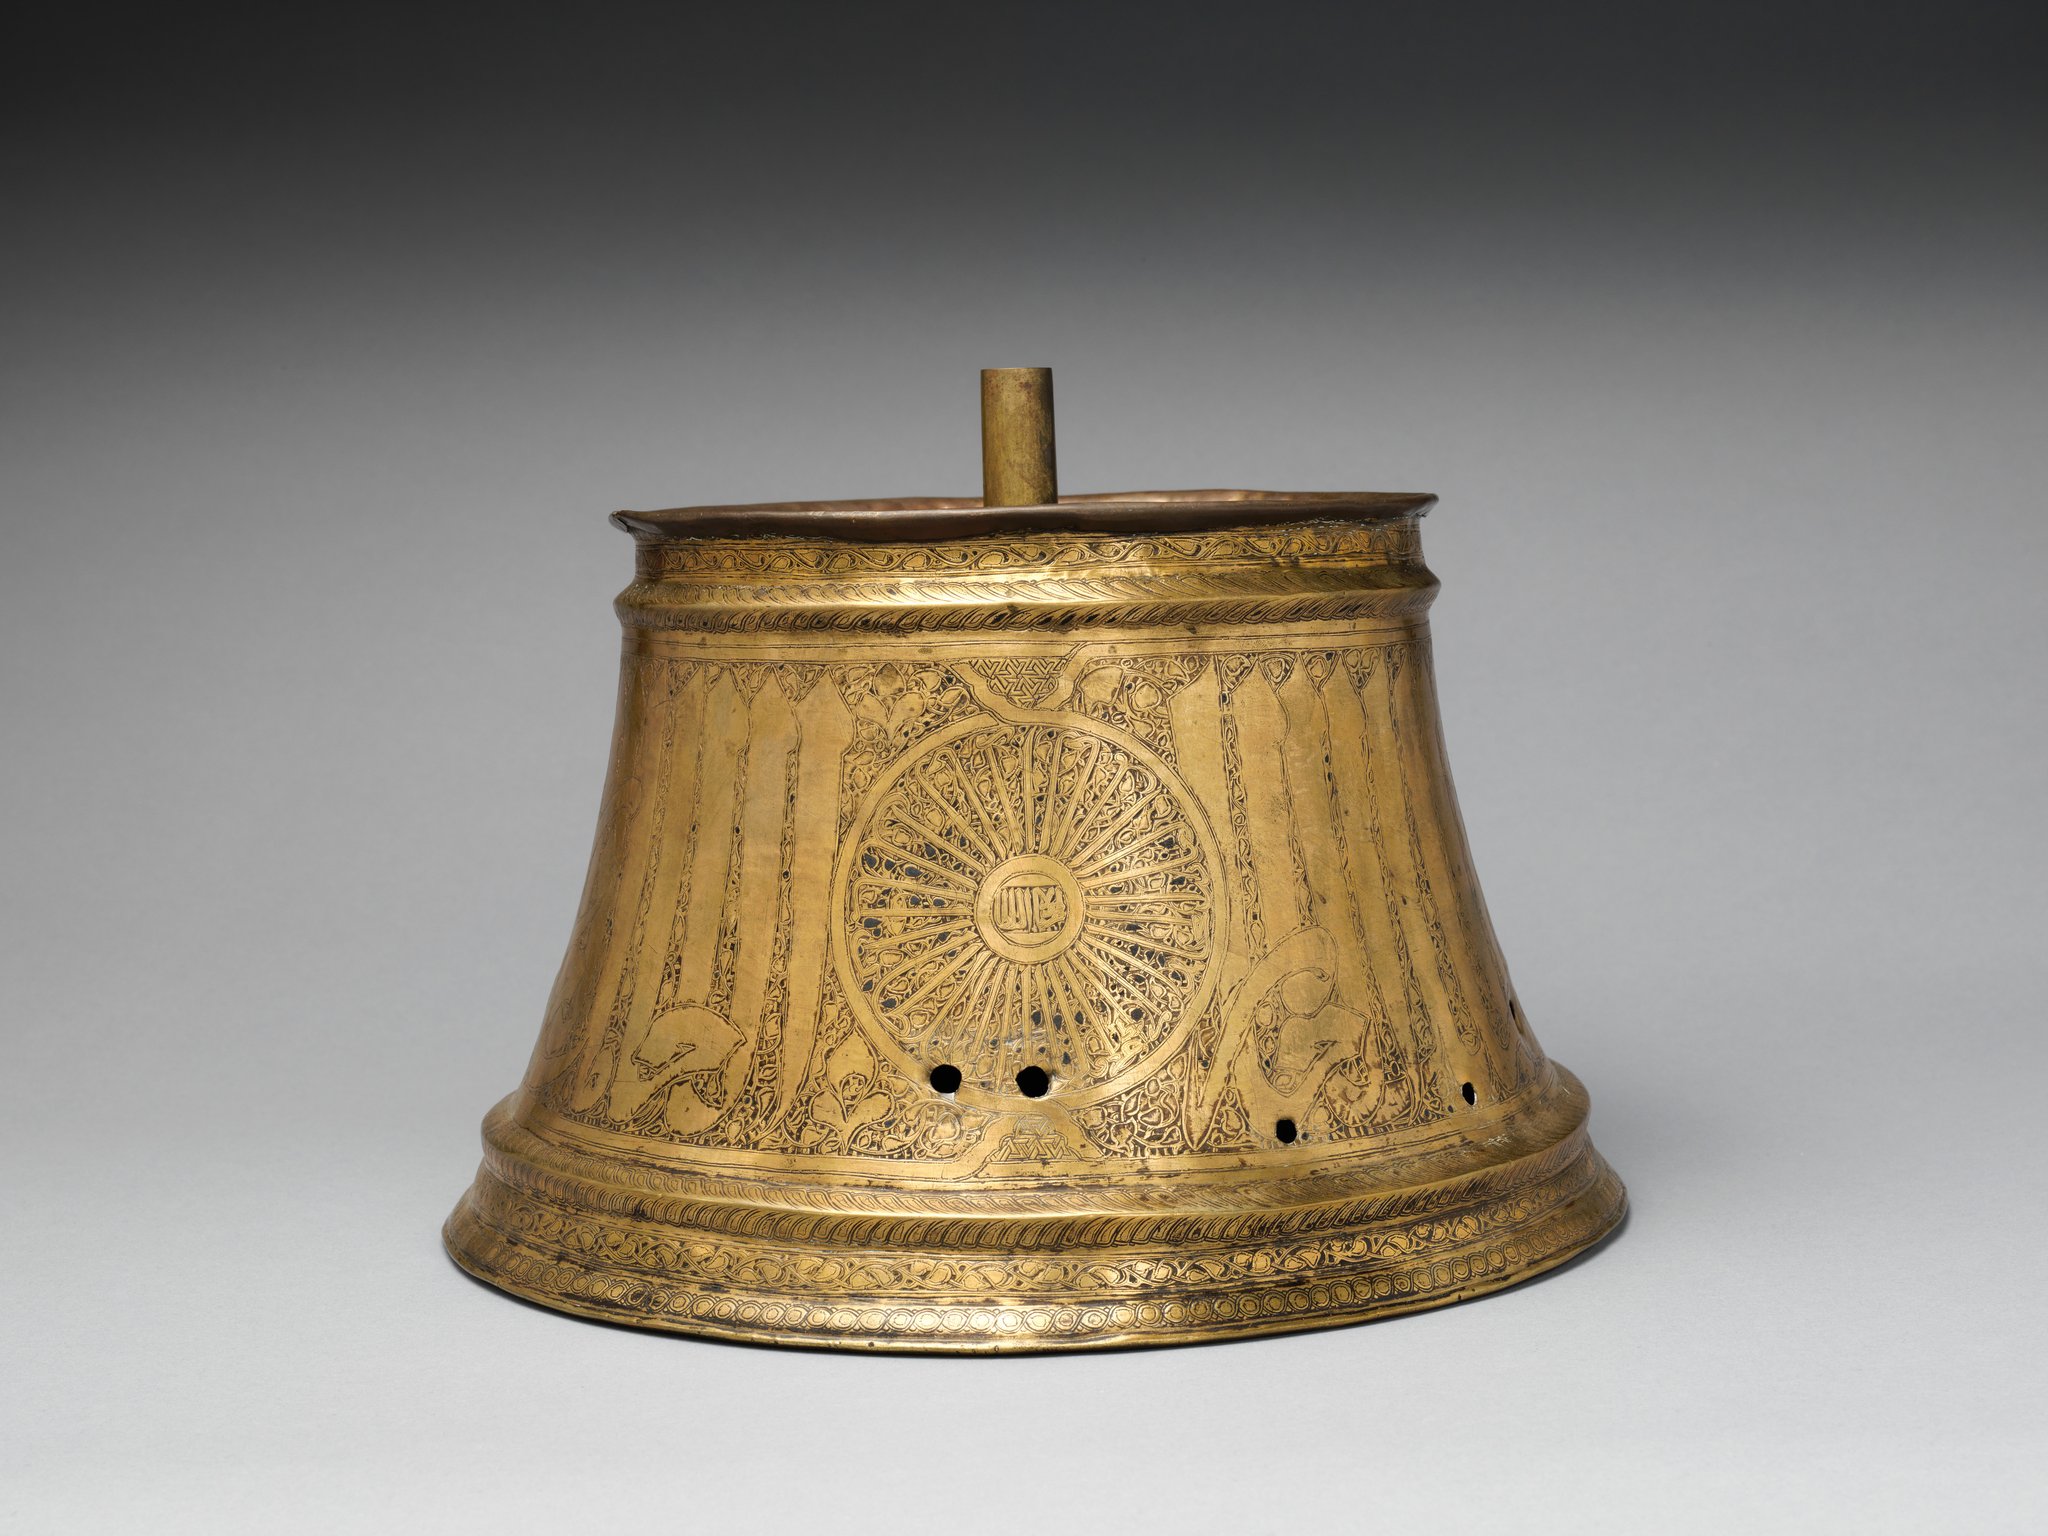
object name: candlestick base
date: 1301-1350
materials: brass, silver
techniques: engraving, inlay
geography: egypt or syria